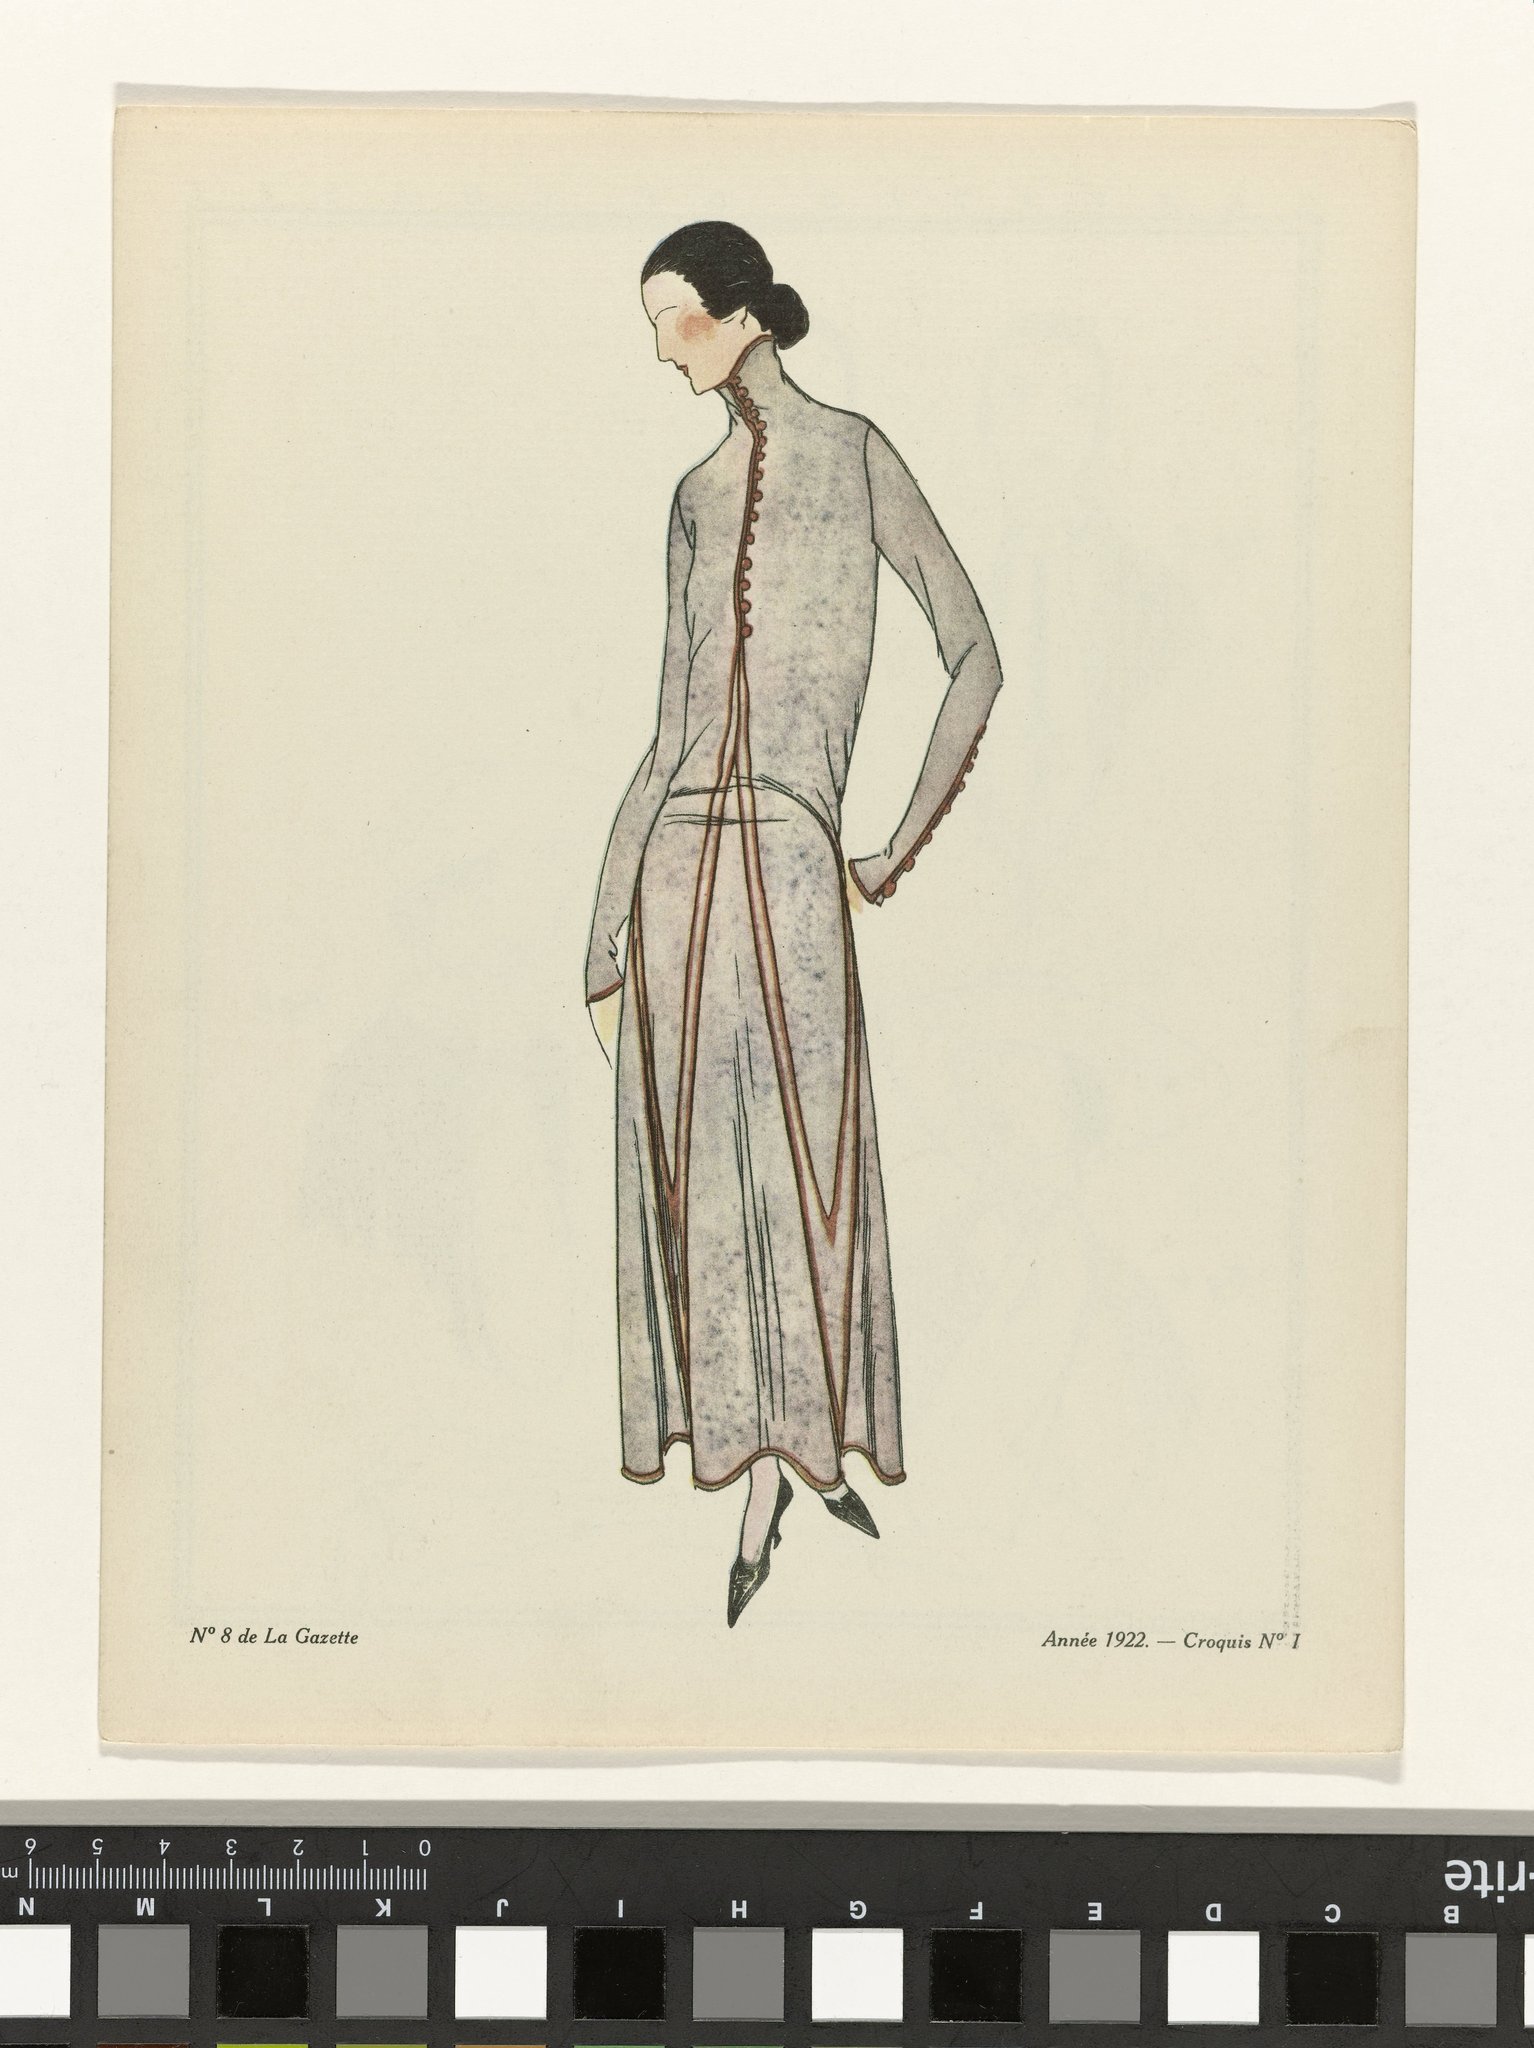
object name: fashion print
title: Gazette du Bon Ton, 1922 - No. 8 : Croquis No 1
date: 1922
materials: paper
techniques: printing, letterpress printing, photochemical processes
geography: new york city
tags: fashion plates, dress, gown (+ women's clothes)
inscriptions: date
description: Japon met een hooggesloten hals en middenvoor en bij de mouwen een rij knopen. Croquis No 1 uit Gazette du Bon Ton 1922, No. 8. Uitleg over de kleding op pagina "Description et explication des planches hors-texte et pages de croquis."